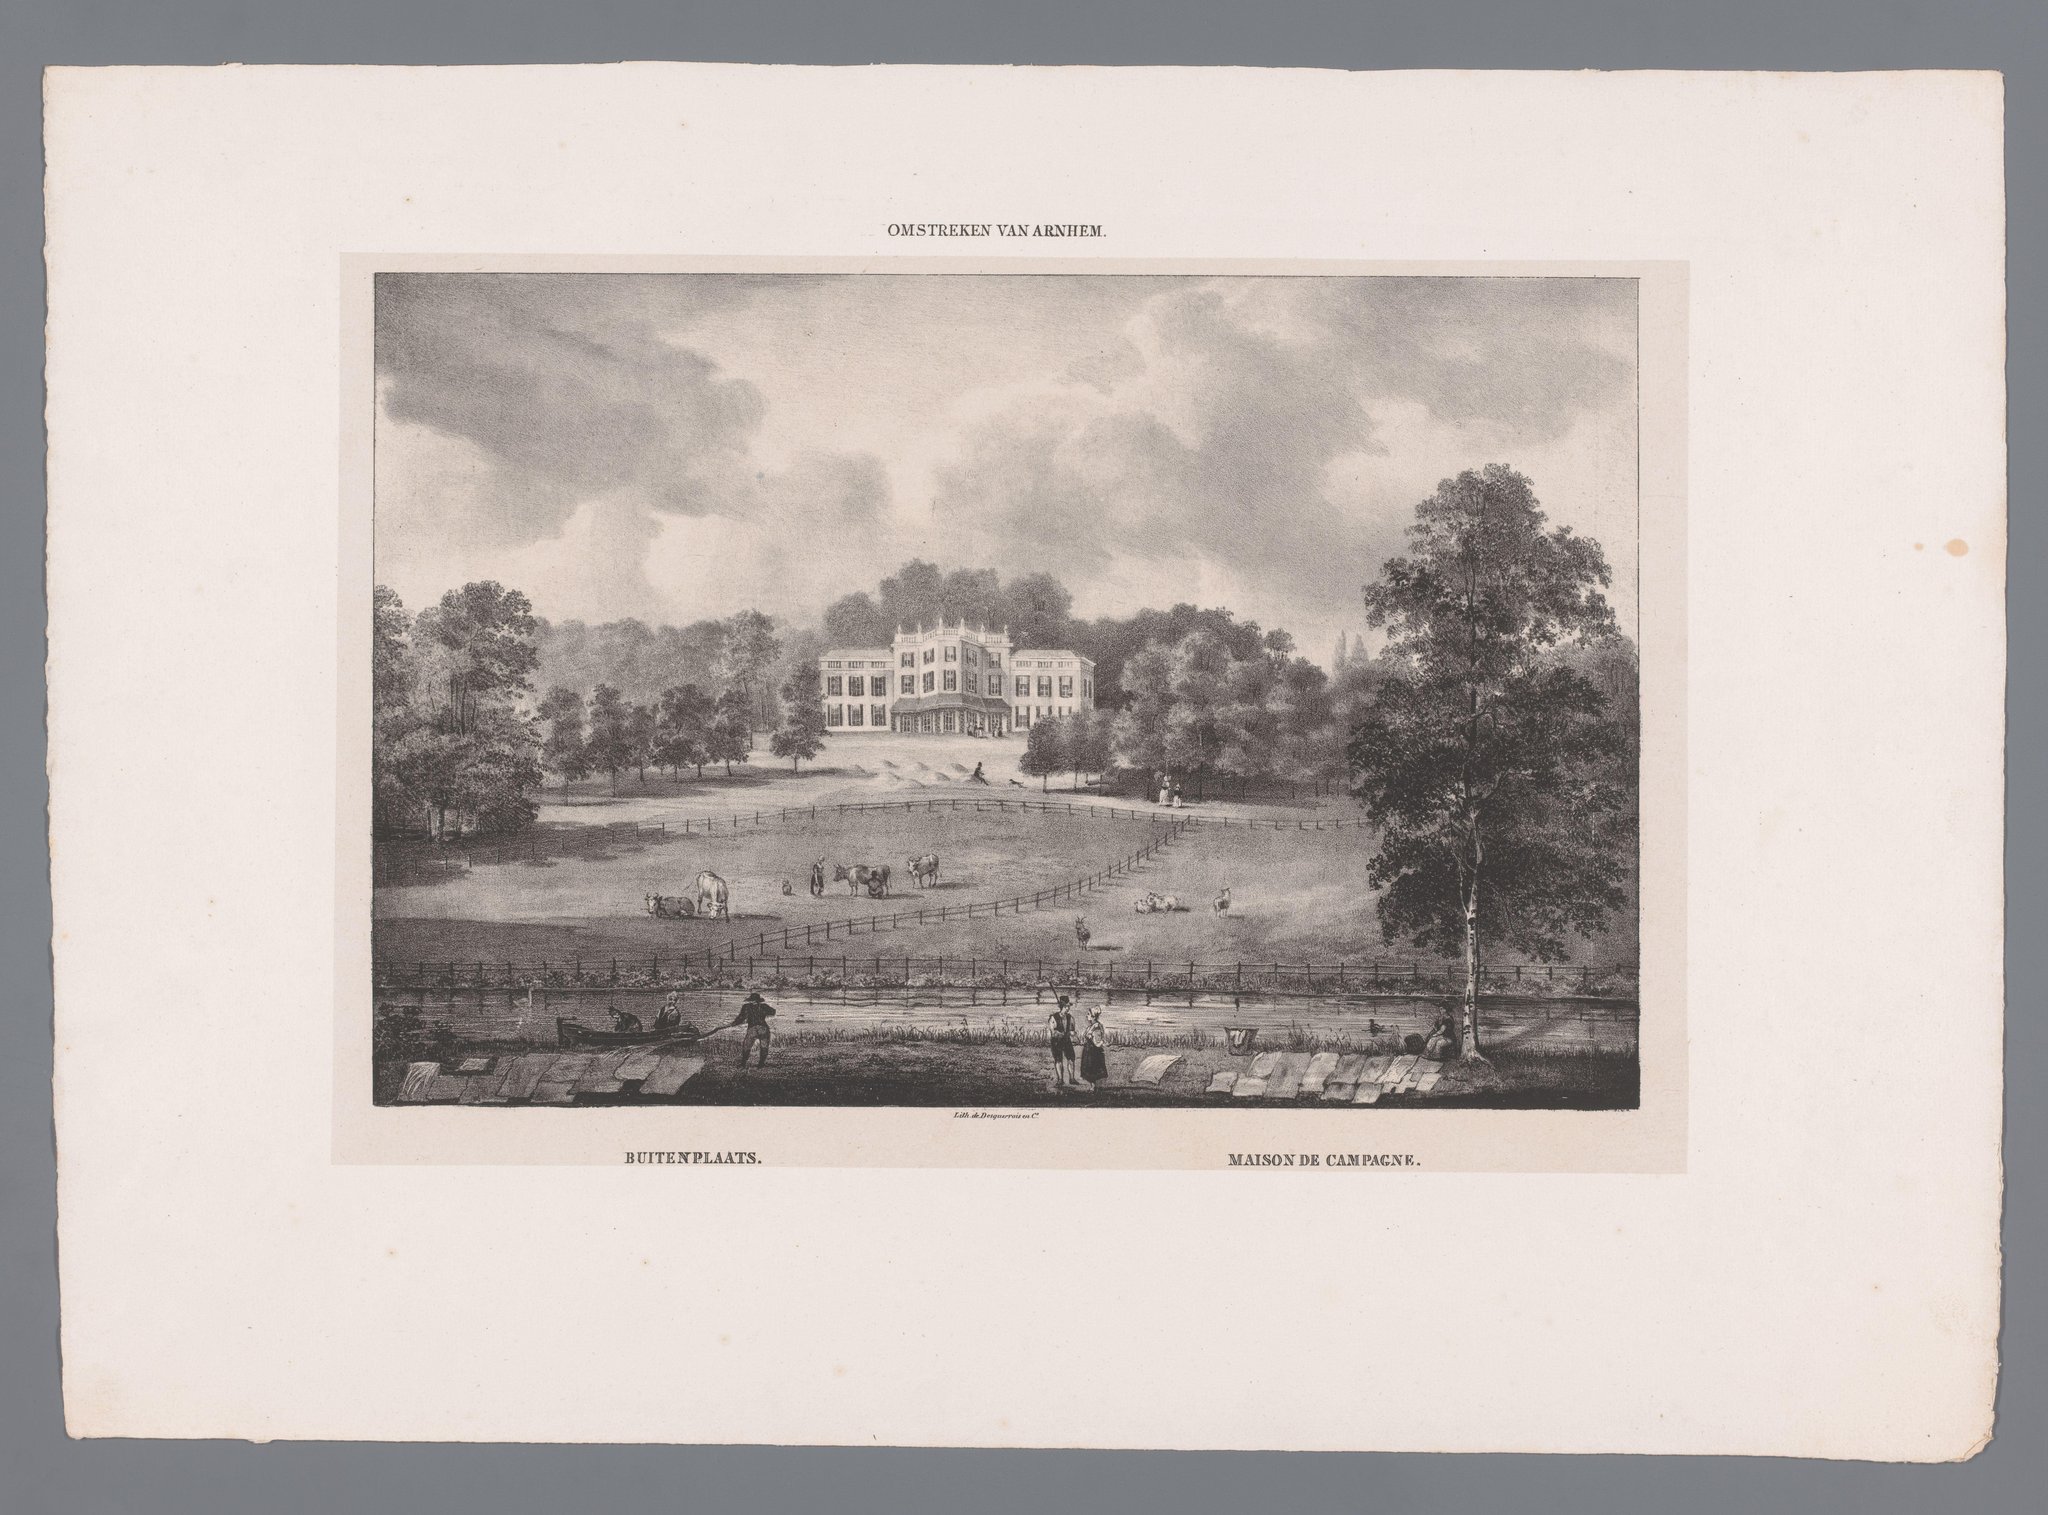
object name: print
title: Buitenplaats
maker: Anonymous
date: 1827-1907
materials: paper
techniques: lithograph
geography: amsterdam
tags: cow (+ care of animals ~ agricultural processes), laying the wash out to dry, country-house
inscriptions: collector's mark: Lugt 2228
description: Op het terrein voor de buitenplaats zijn weilanden met koeien en een rivier. Enkele figuren zijn bezig linnen te laten drogen aan de waterkant. Maakt deel uit van een omslag met zes prenten.